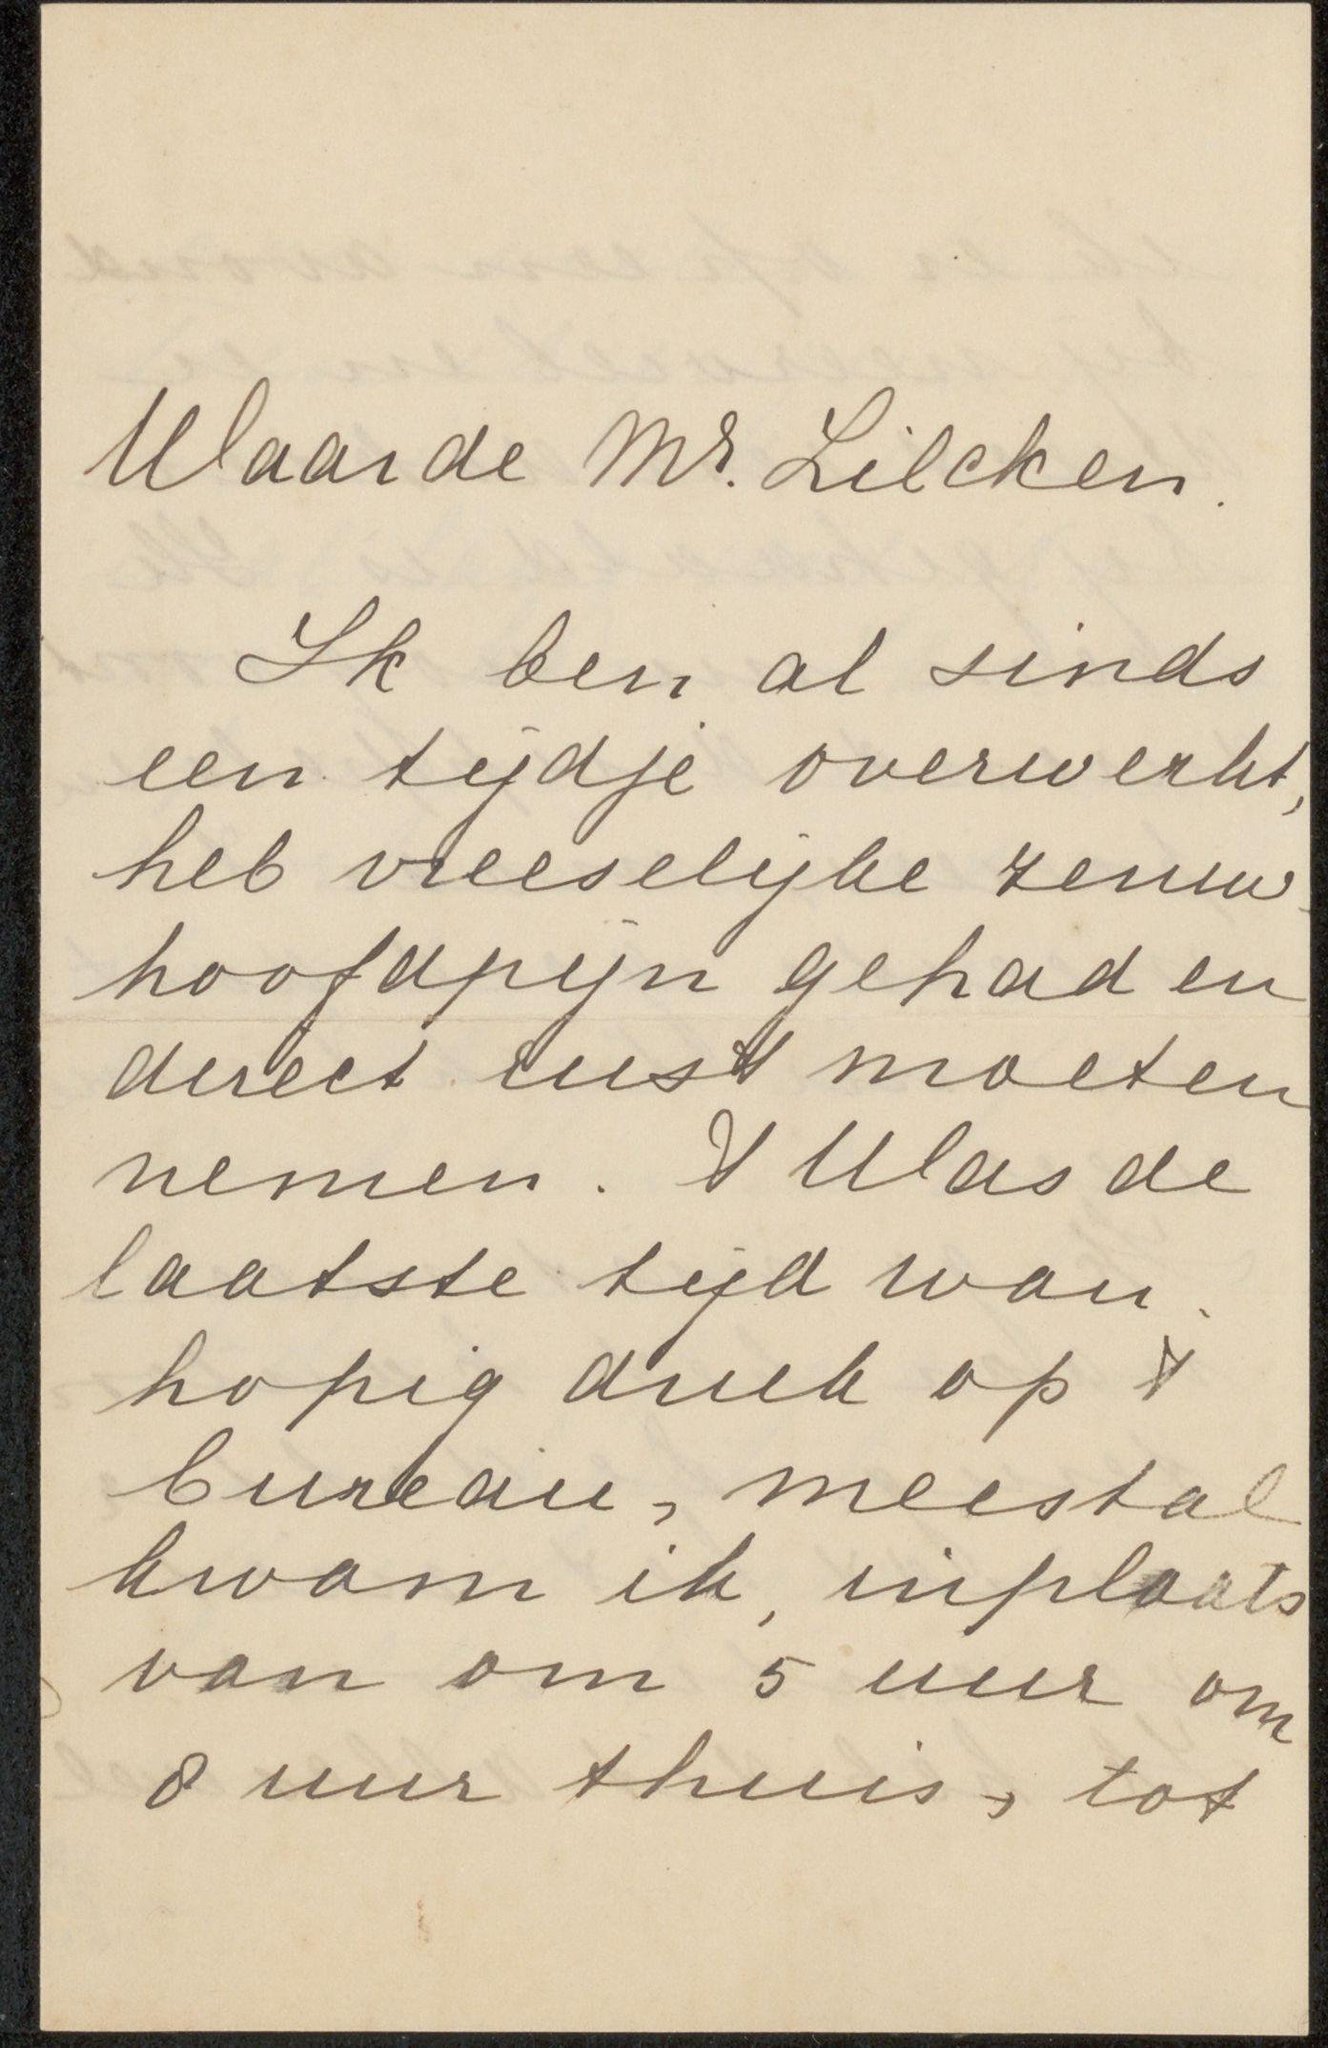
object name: letter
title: Brief aan Philip Zilcken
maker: jo geul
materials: ink, paper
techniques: pen, writing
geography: the hague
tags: painter, draughtsman, philip zilcken, diseases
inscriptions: collector's mark: ‘RPK’